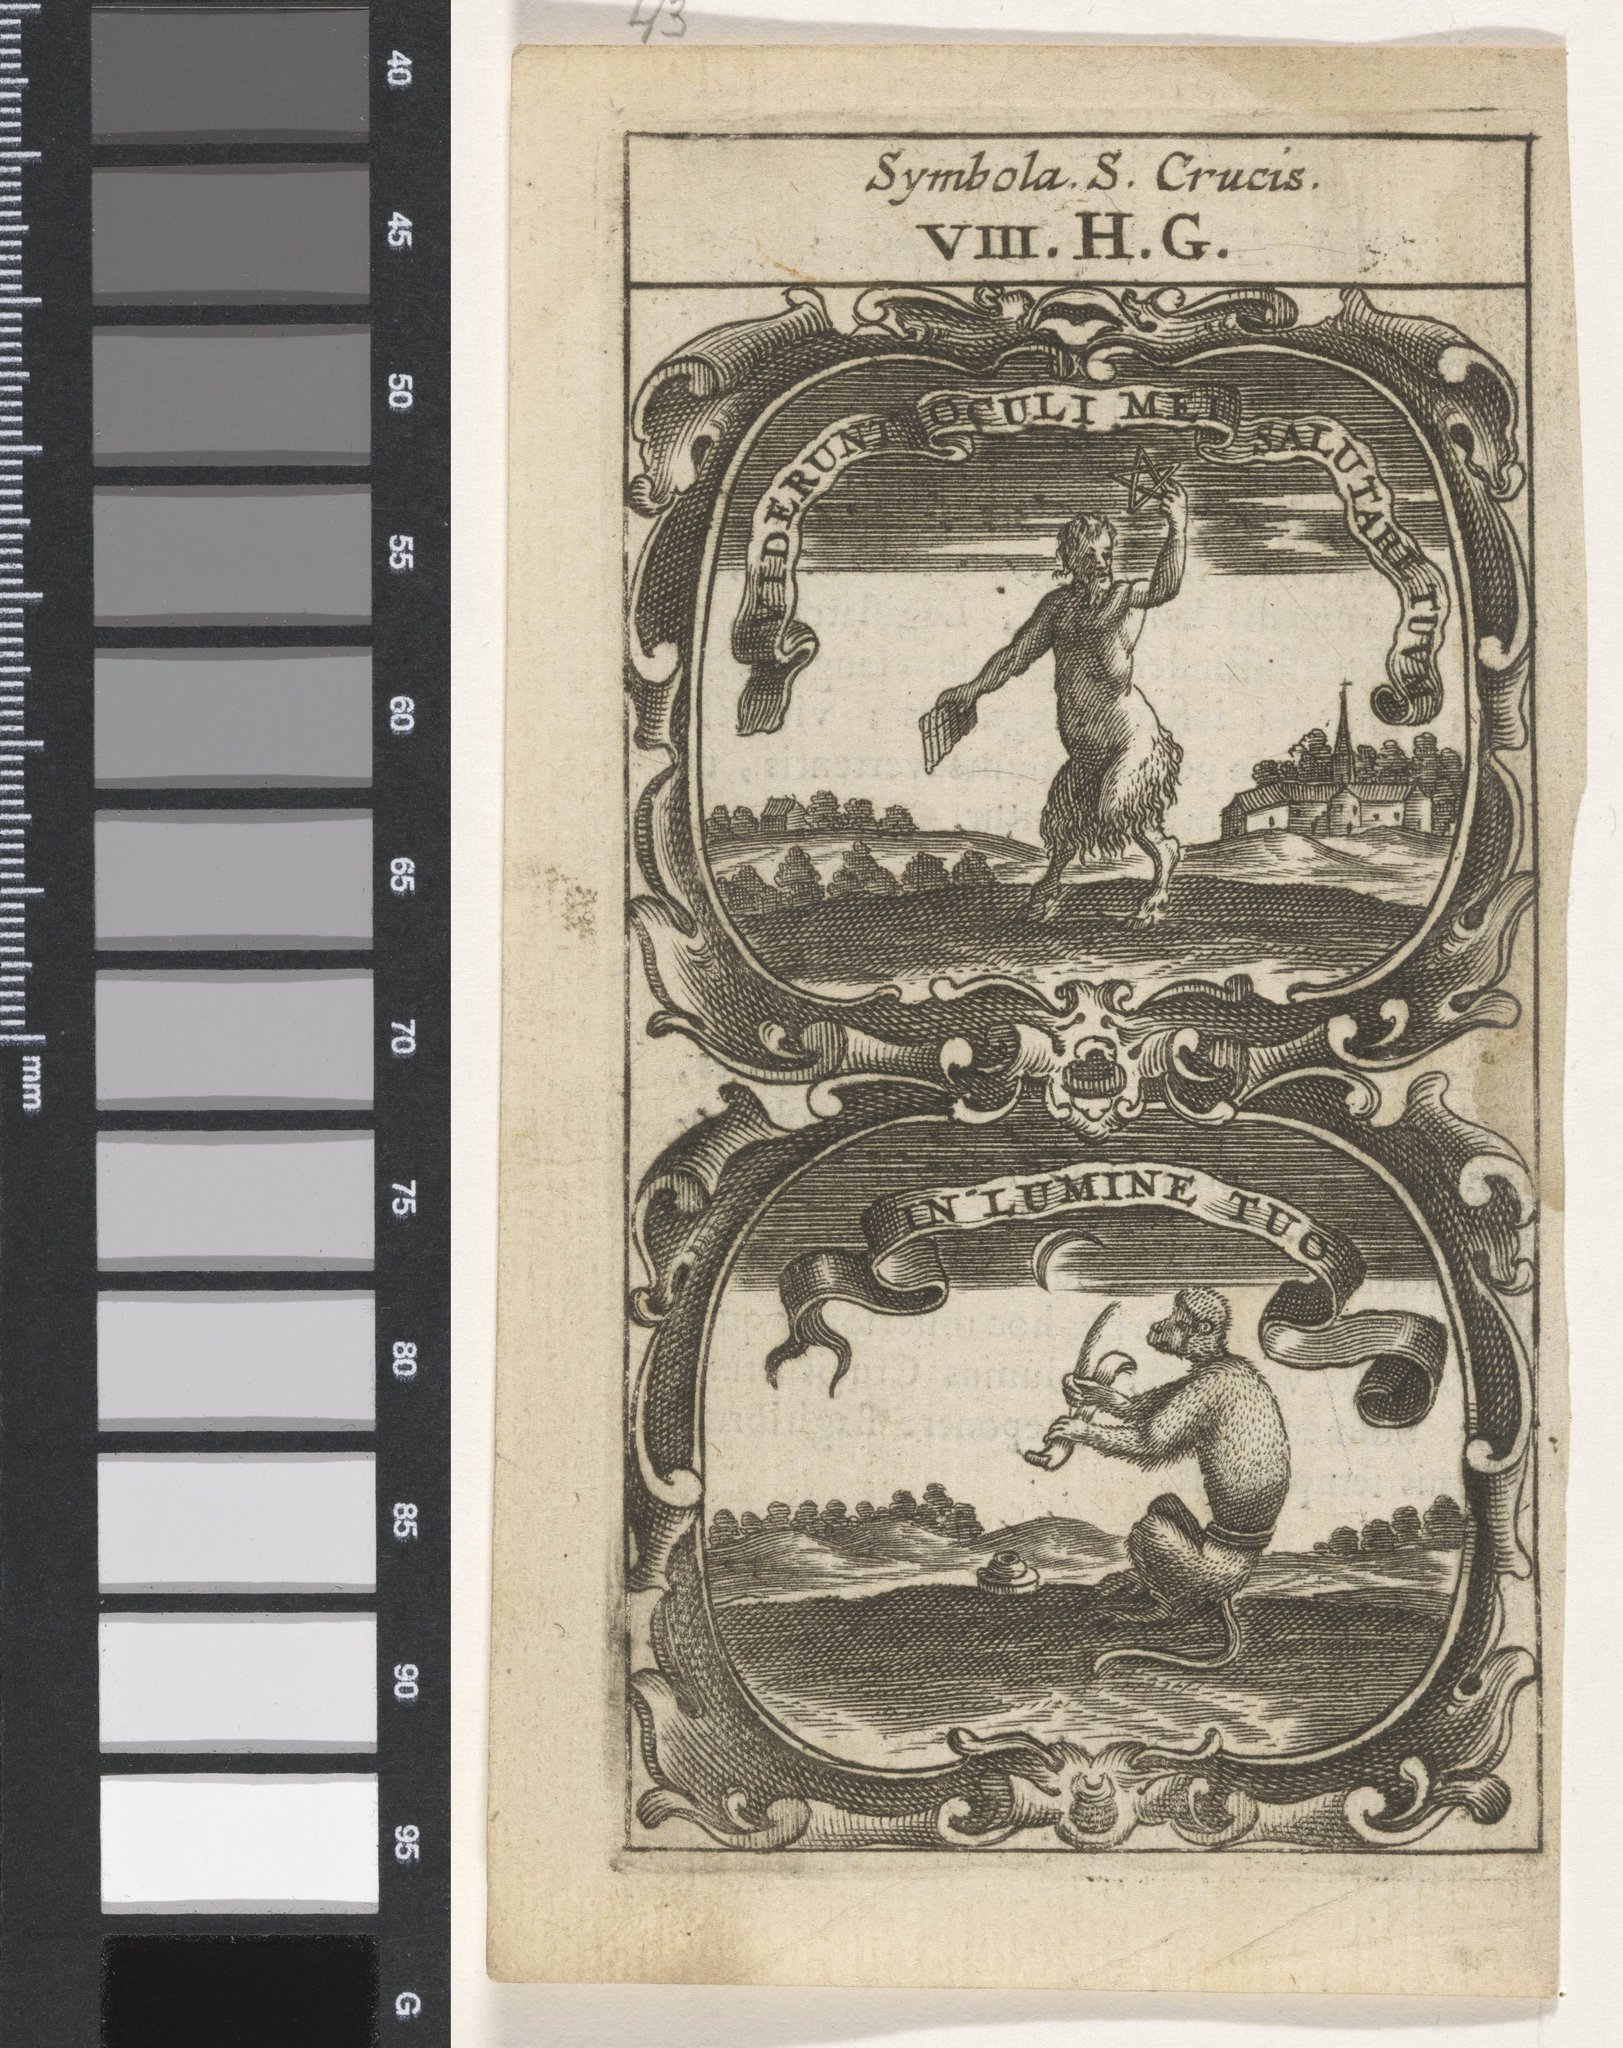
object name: book illustration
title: Symbola Divina et Humana Pontificum Imperatorum Regum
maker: Anonymous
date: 1666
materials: paper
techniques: engraving, letterpress printing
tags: monkeys, apes, writing tools, pentagram ~ magic mathematical figures, satyr(s) (in general)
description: Een embleem met twee voorstellingen. Boven een landschap met een kerk en een sater met panfluit en pentagram. Daaronder een landschap bij maanlicht met een aap. Voor hem op de grond staat een inktpot. In zijn poten heeft hij een banderol en een schrijfveer.